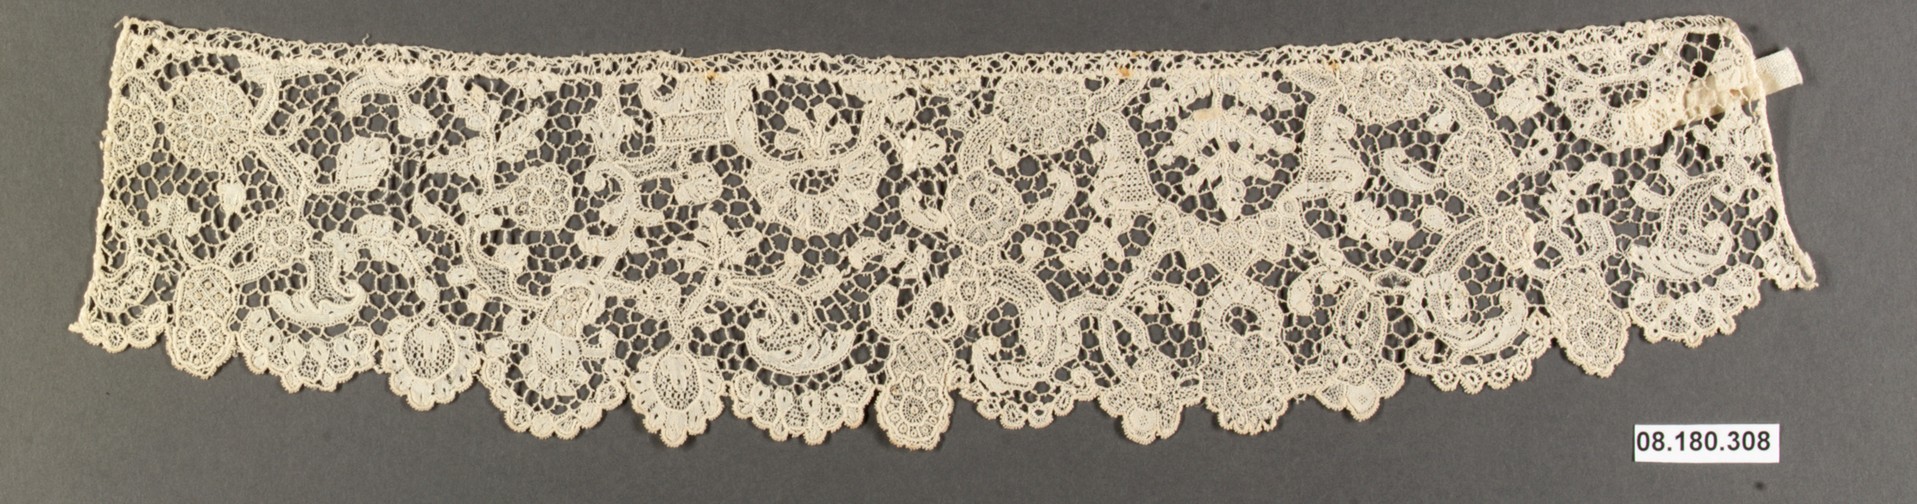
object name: collar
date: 1701-1800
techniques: lace